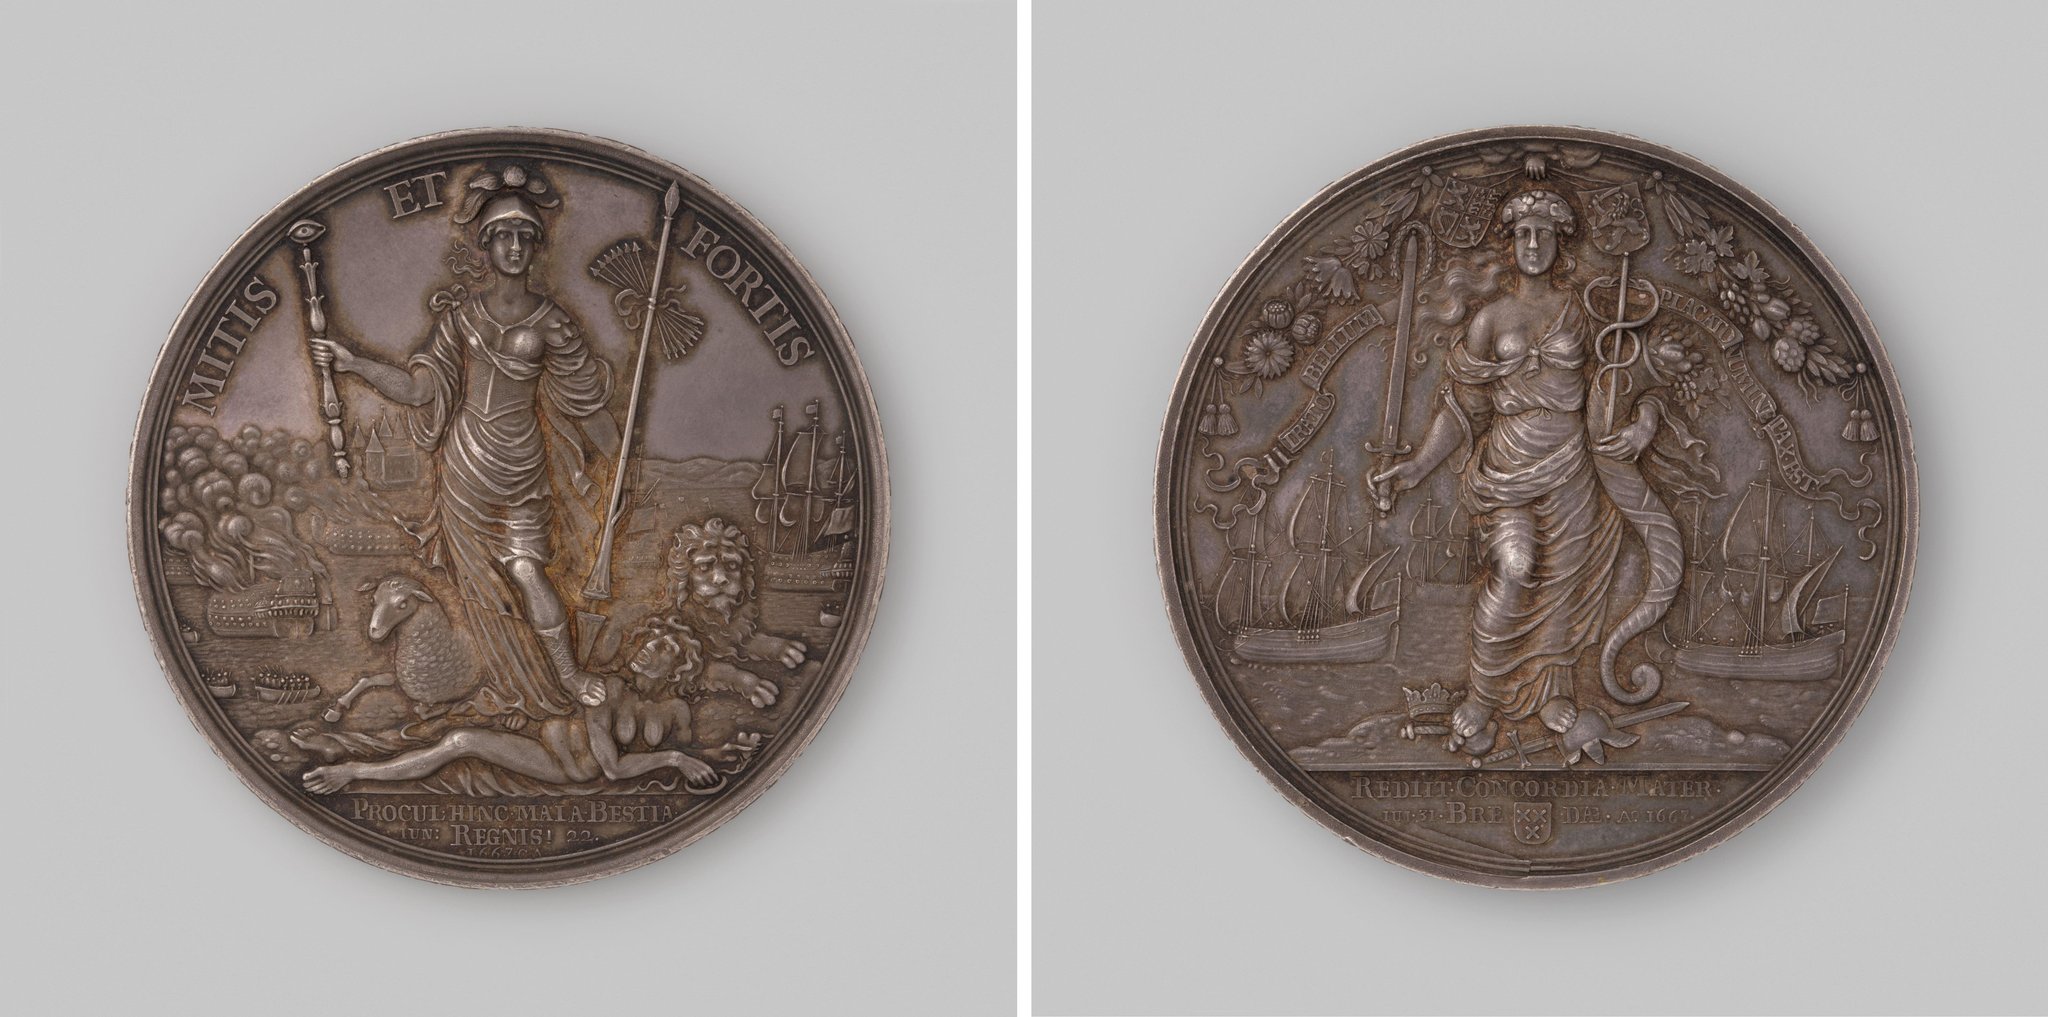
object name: medal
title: Vrede van Breda en vernietiging van de Engelse vloot bij Chatham (Mala Bestia-penning)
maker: christoffel adolphi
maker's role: medailleur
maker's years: 1630-1684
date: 1667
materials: silver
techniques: striking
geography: amsterdam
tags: england, raid on the medway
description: Penning geslagen op last van de Staten van Holland.